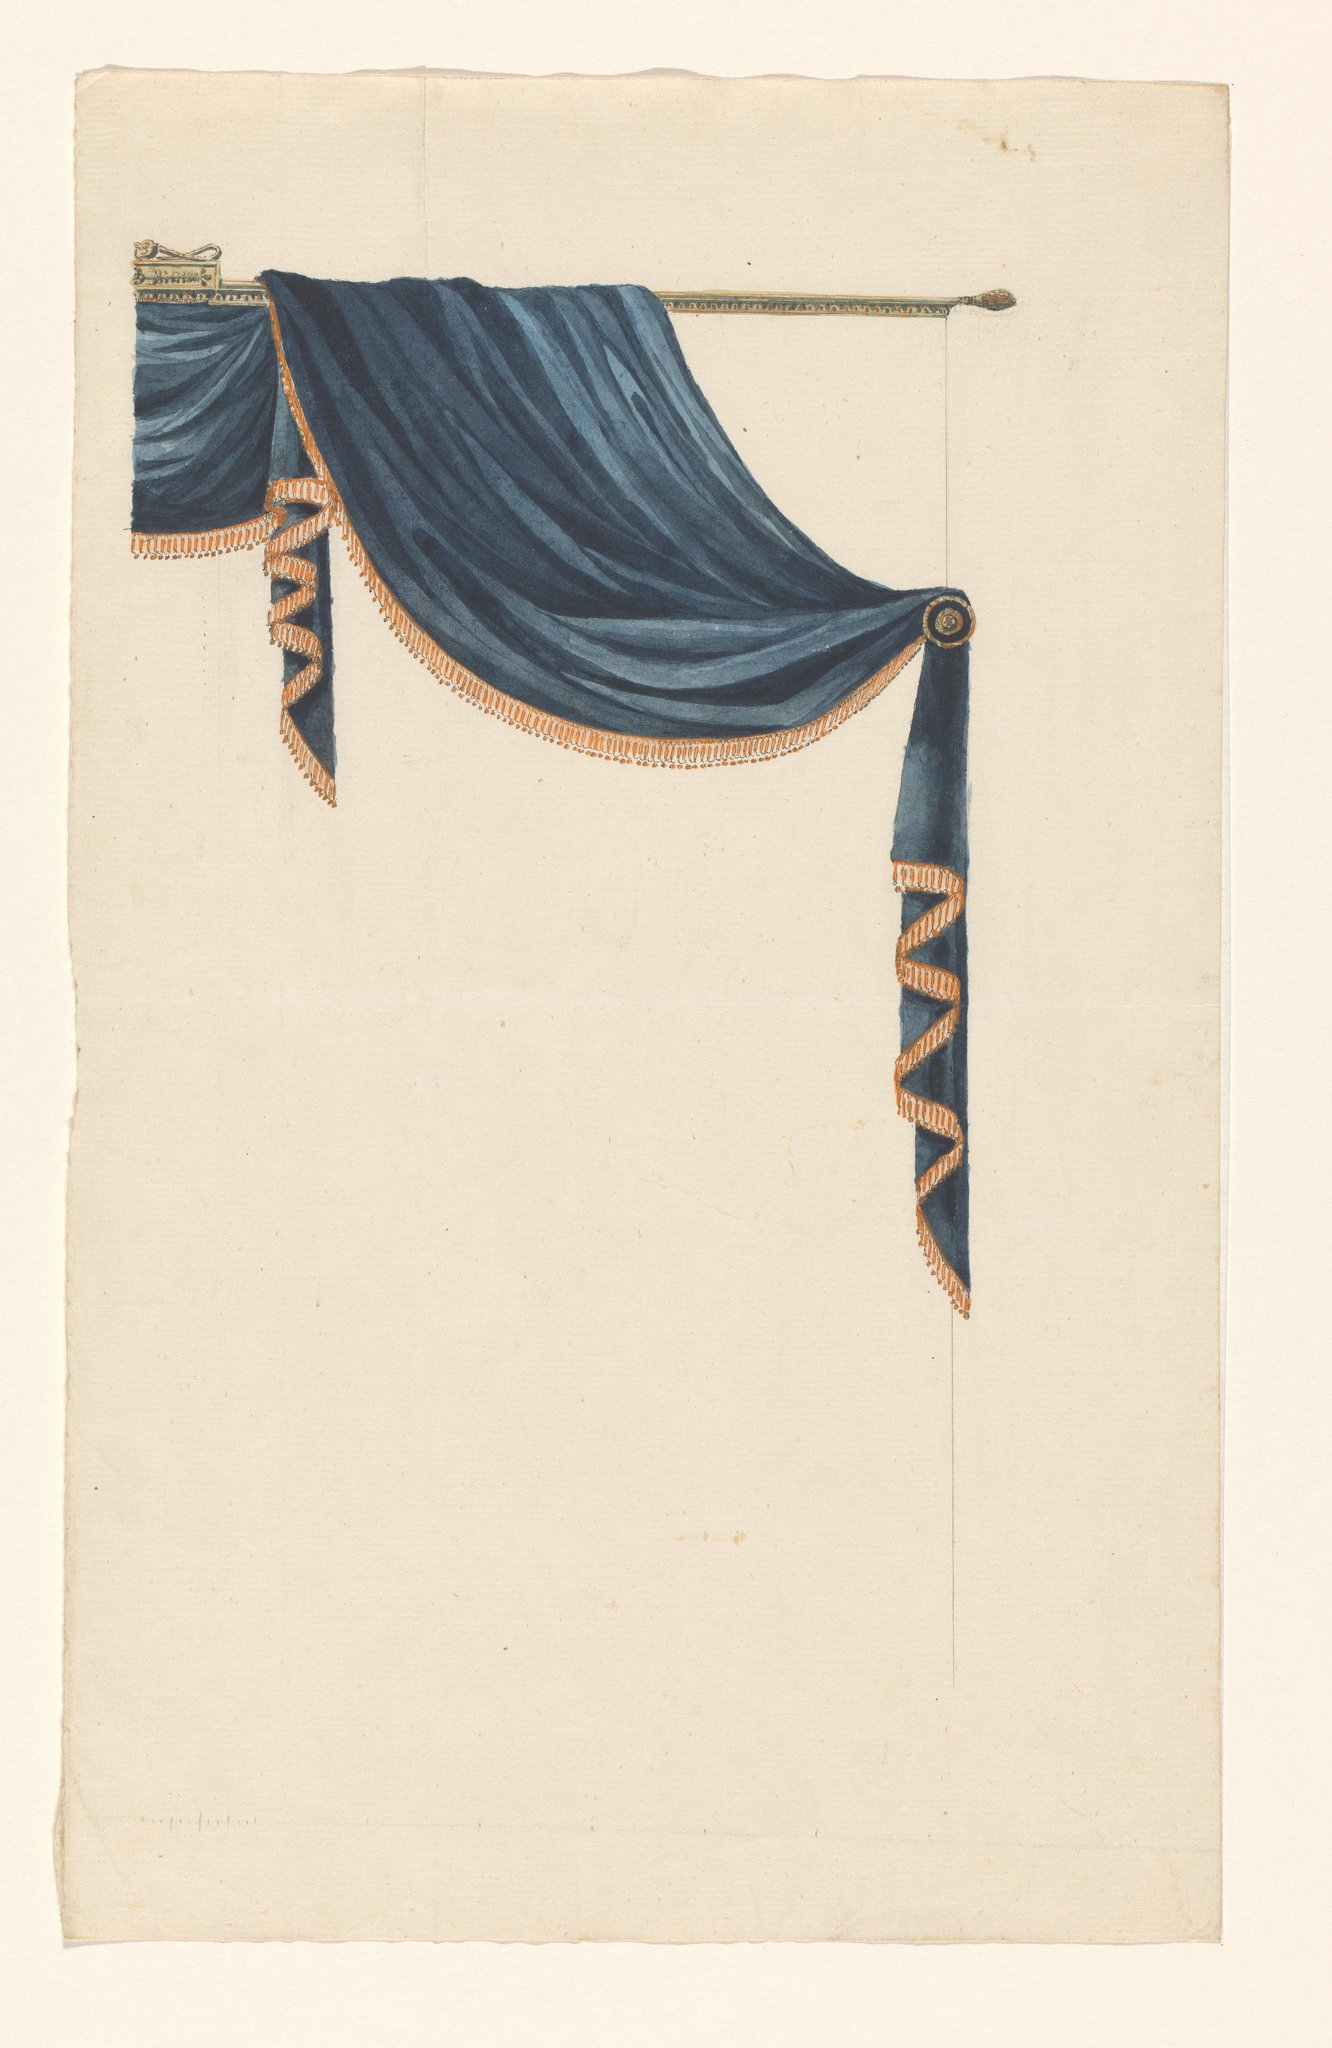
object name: design drawing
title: Ontwerp voor een over een vergulde roede gedrapeerd gordijn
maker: Anonymous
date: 1810-1820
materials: graphite, ink, paper, watercolor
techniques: aquarelle, brush, pen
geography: netherlands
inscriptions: watermark